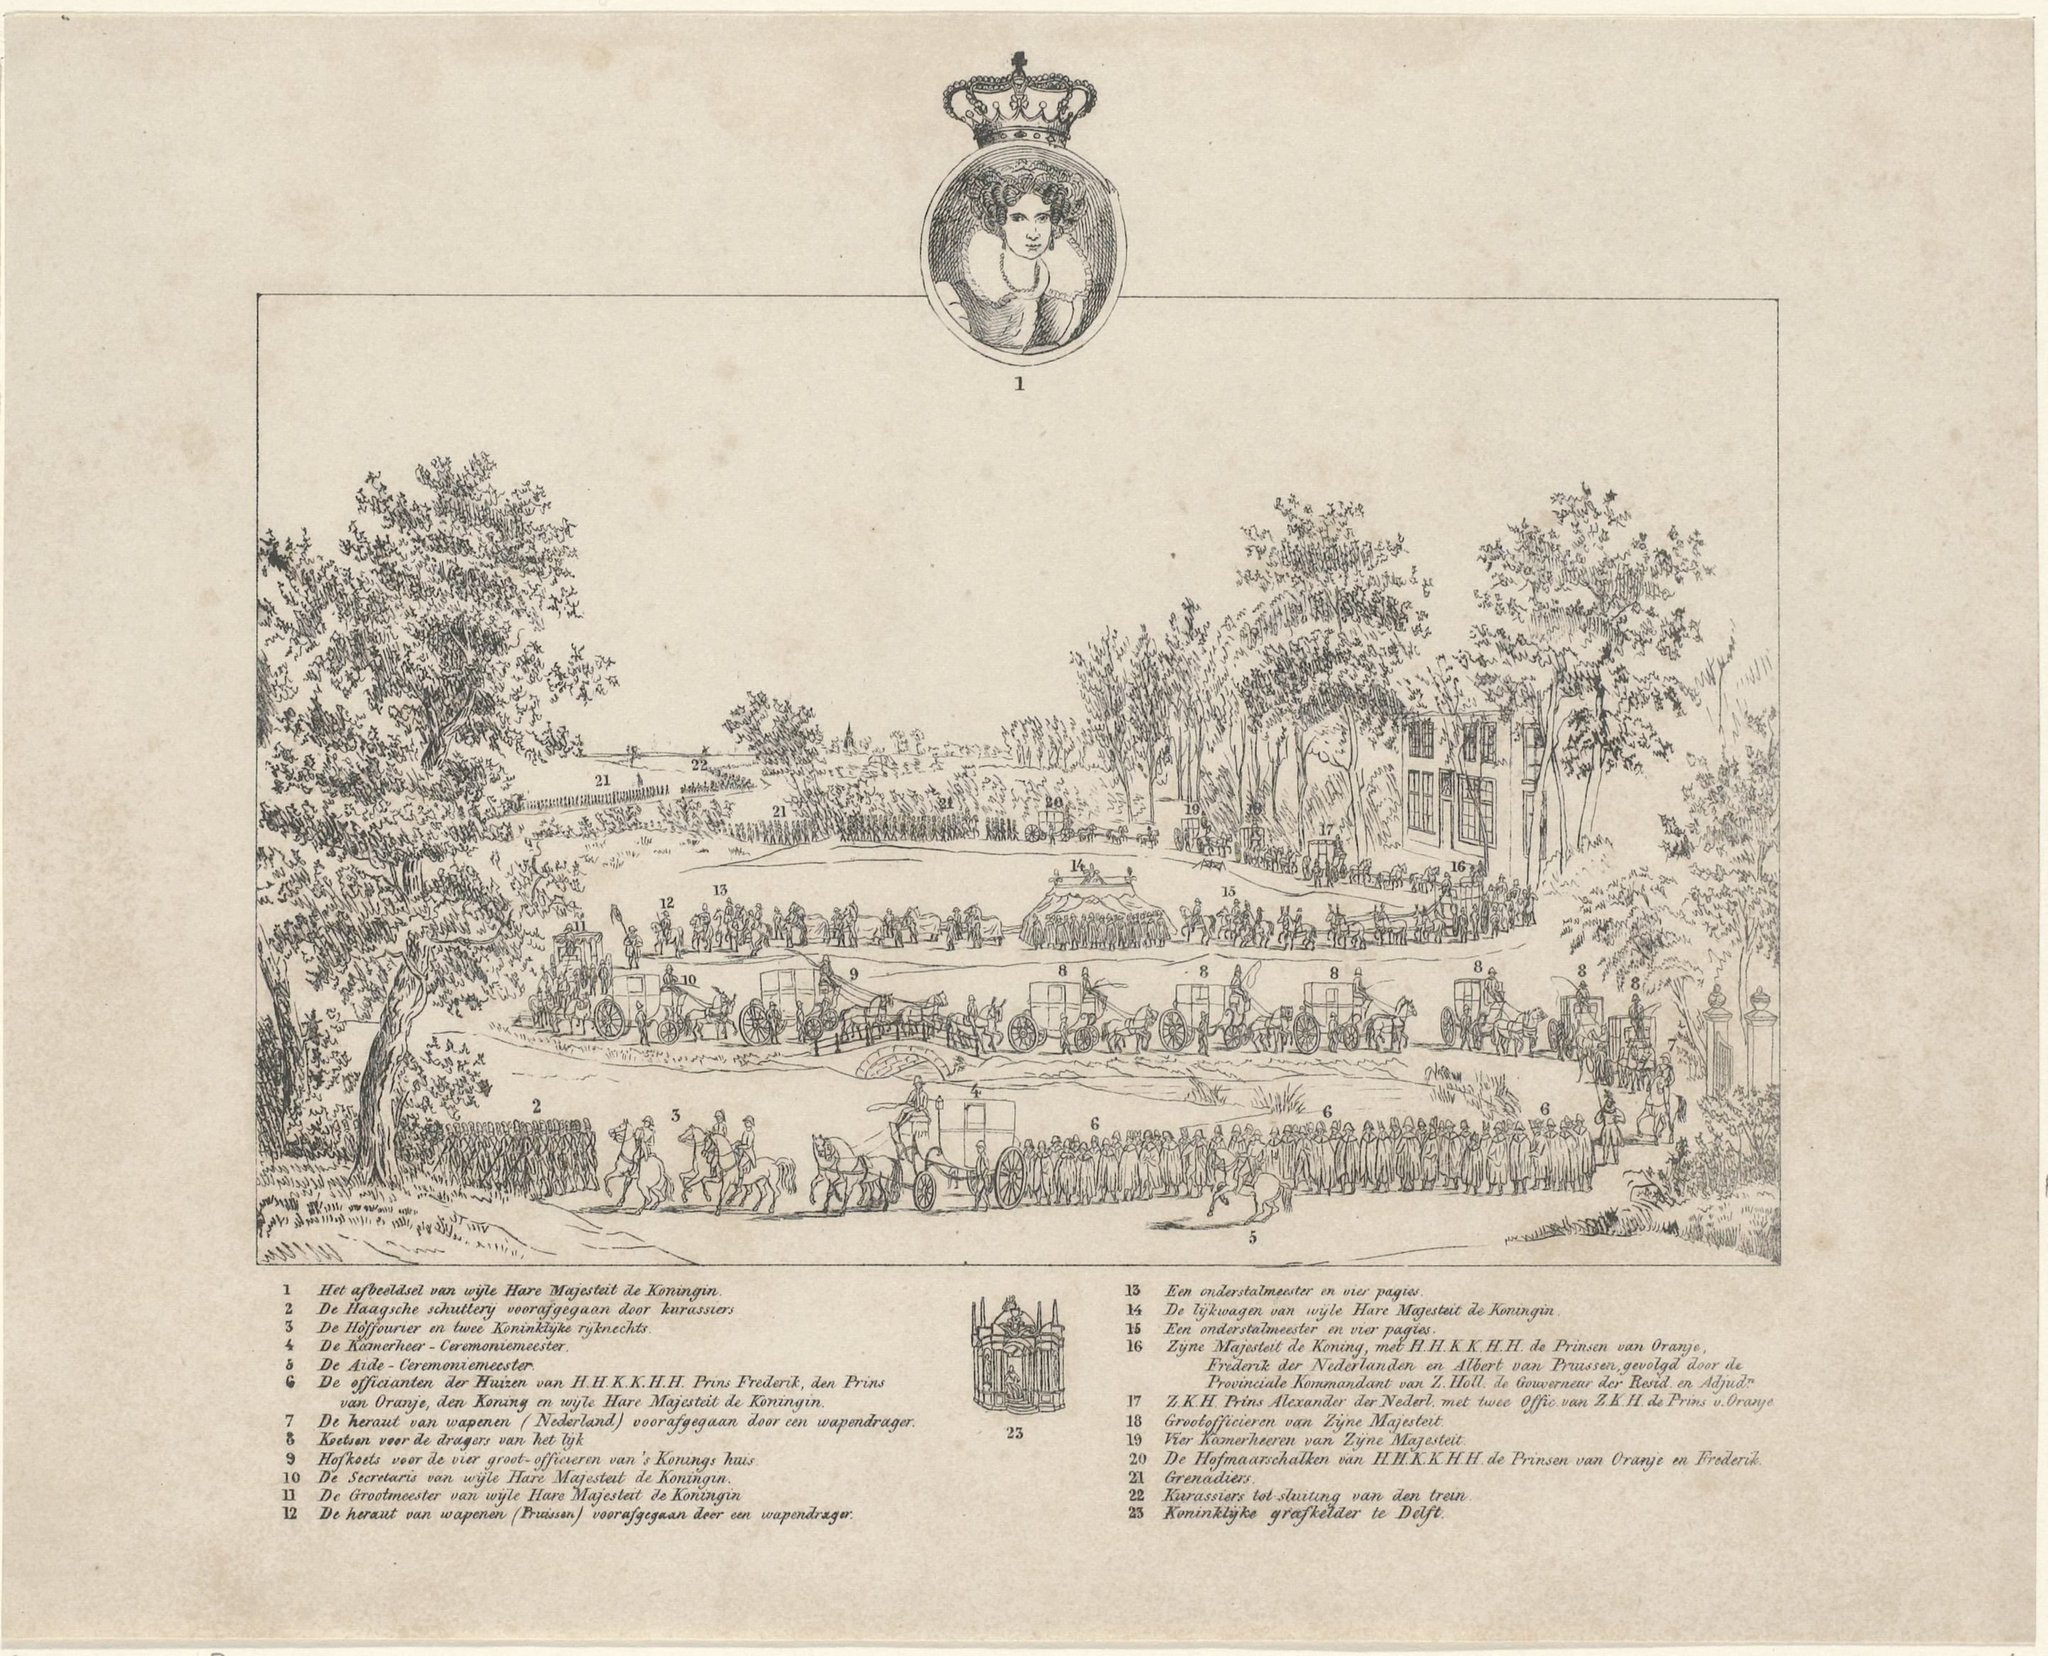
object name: print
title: Sleutel bij de prent: Plegtige ter aarde bestelling van H.M. de Koningin der Nederlanden, op den 26 October 1837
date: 1837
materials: paper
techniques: lithograph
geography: netherlands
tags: berlin, wilhelmina frederica louisa (koningin der nederlanden), cortege, funeral procession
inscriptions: collector's mark: Lugt 2228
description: Sleutel bij de prent van de begrafenisstoet van koningin Wilhelmina van Pruisen onderweg van Den Haag naar Delft, 26 oktober 1837. Met verklaring van de voorstelling in nummers 1-23.